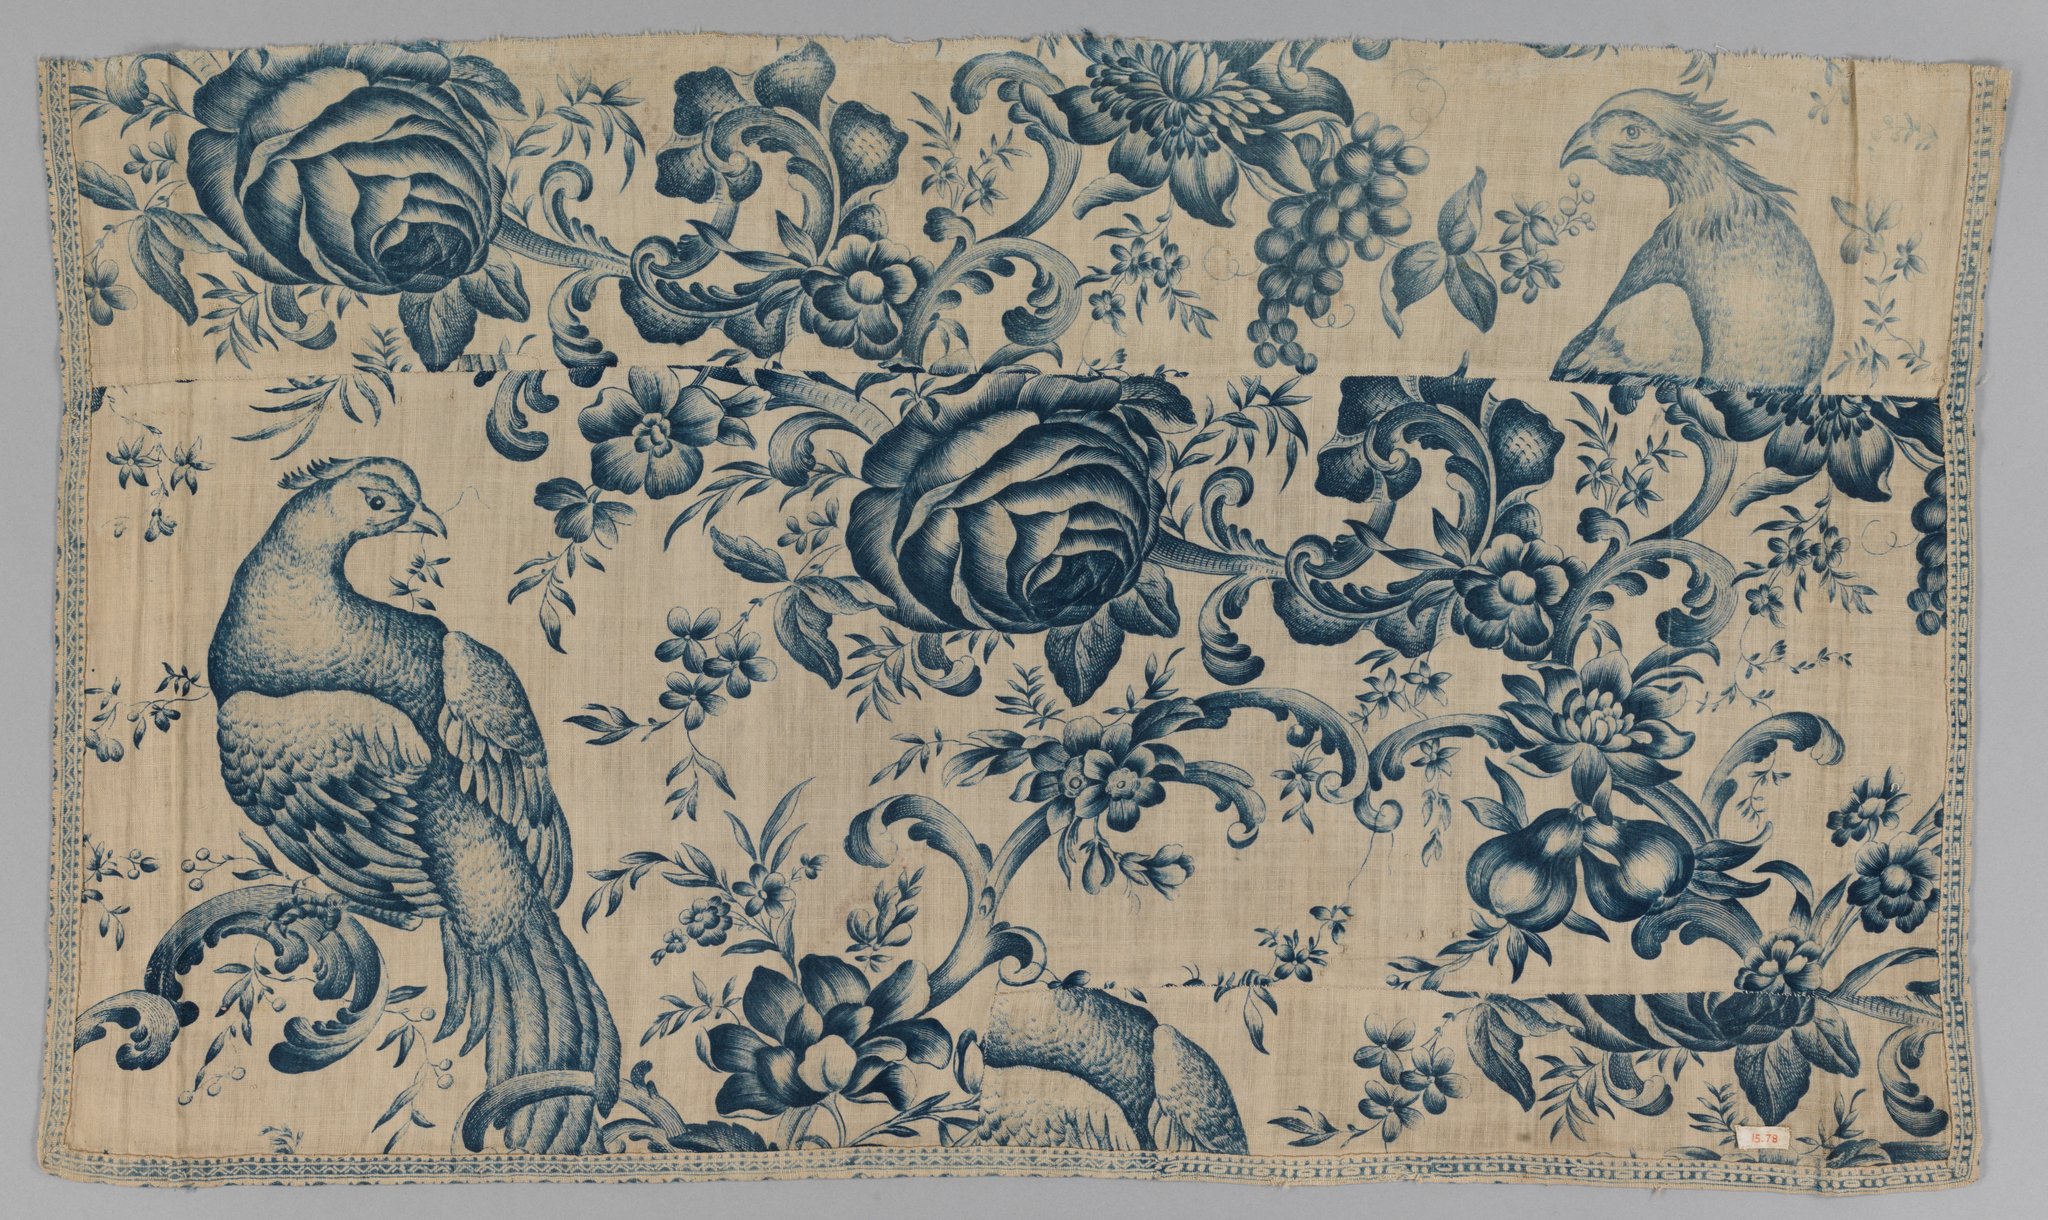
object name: piece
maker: bromley hall printworks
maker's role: manufactory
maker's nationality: english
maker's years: 1694-1823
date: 1765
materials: cotton, linen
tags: birds,flowers,leaves